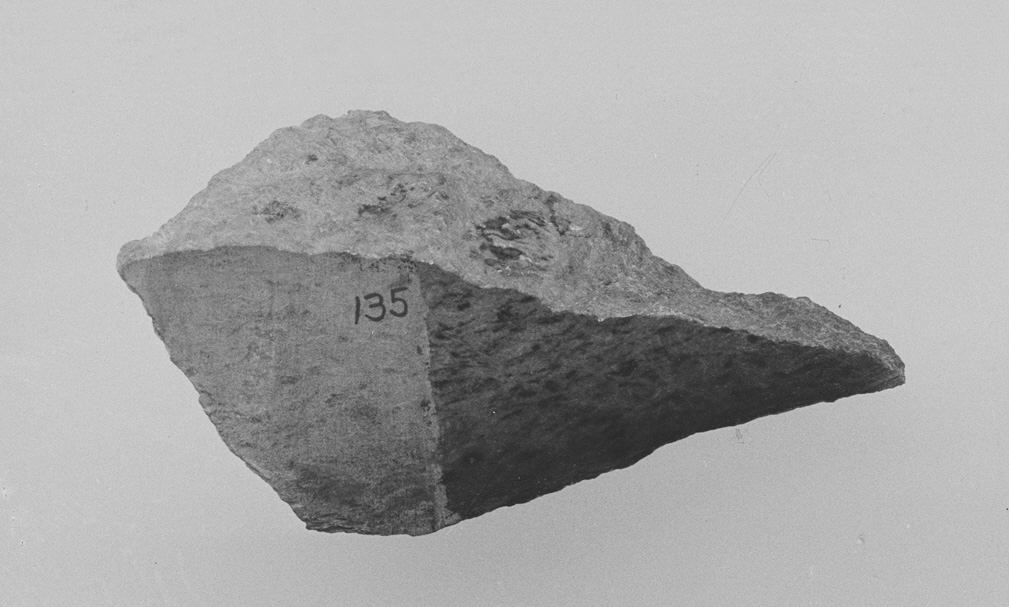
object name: fragment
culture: german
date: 1902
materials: jade